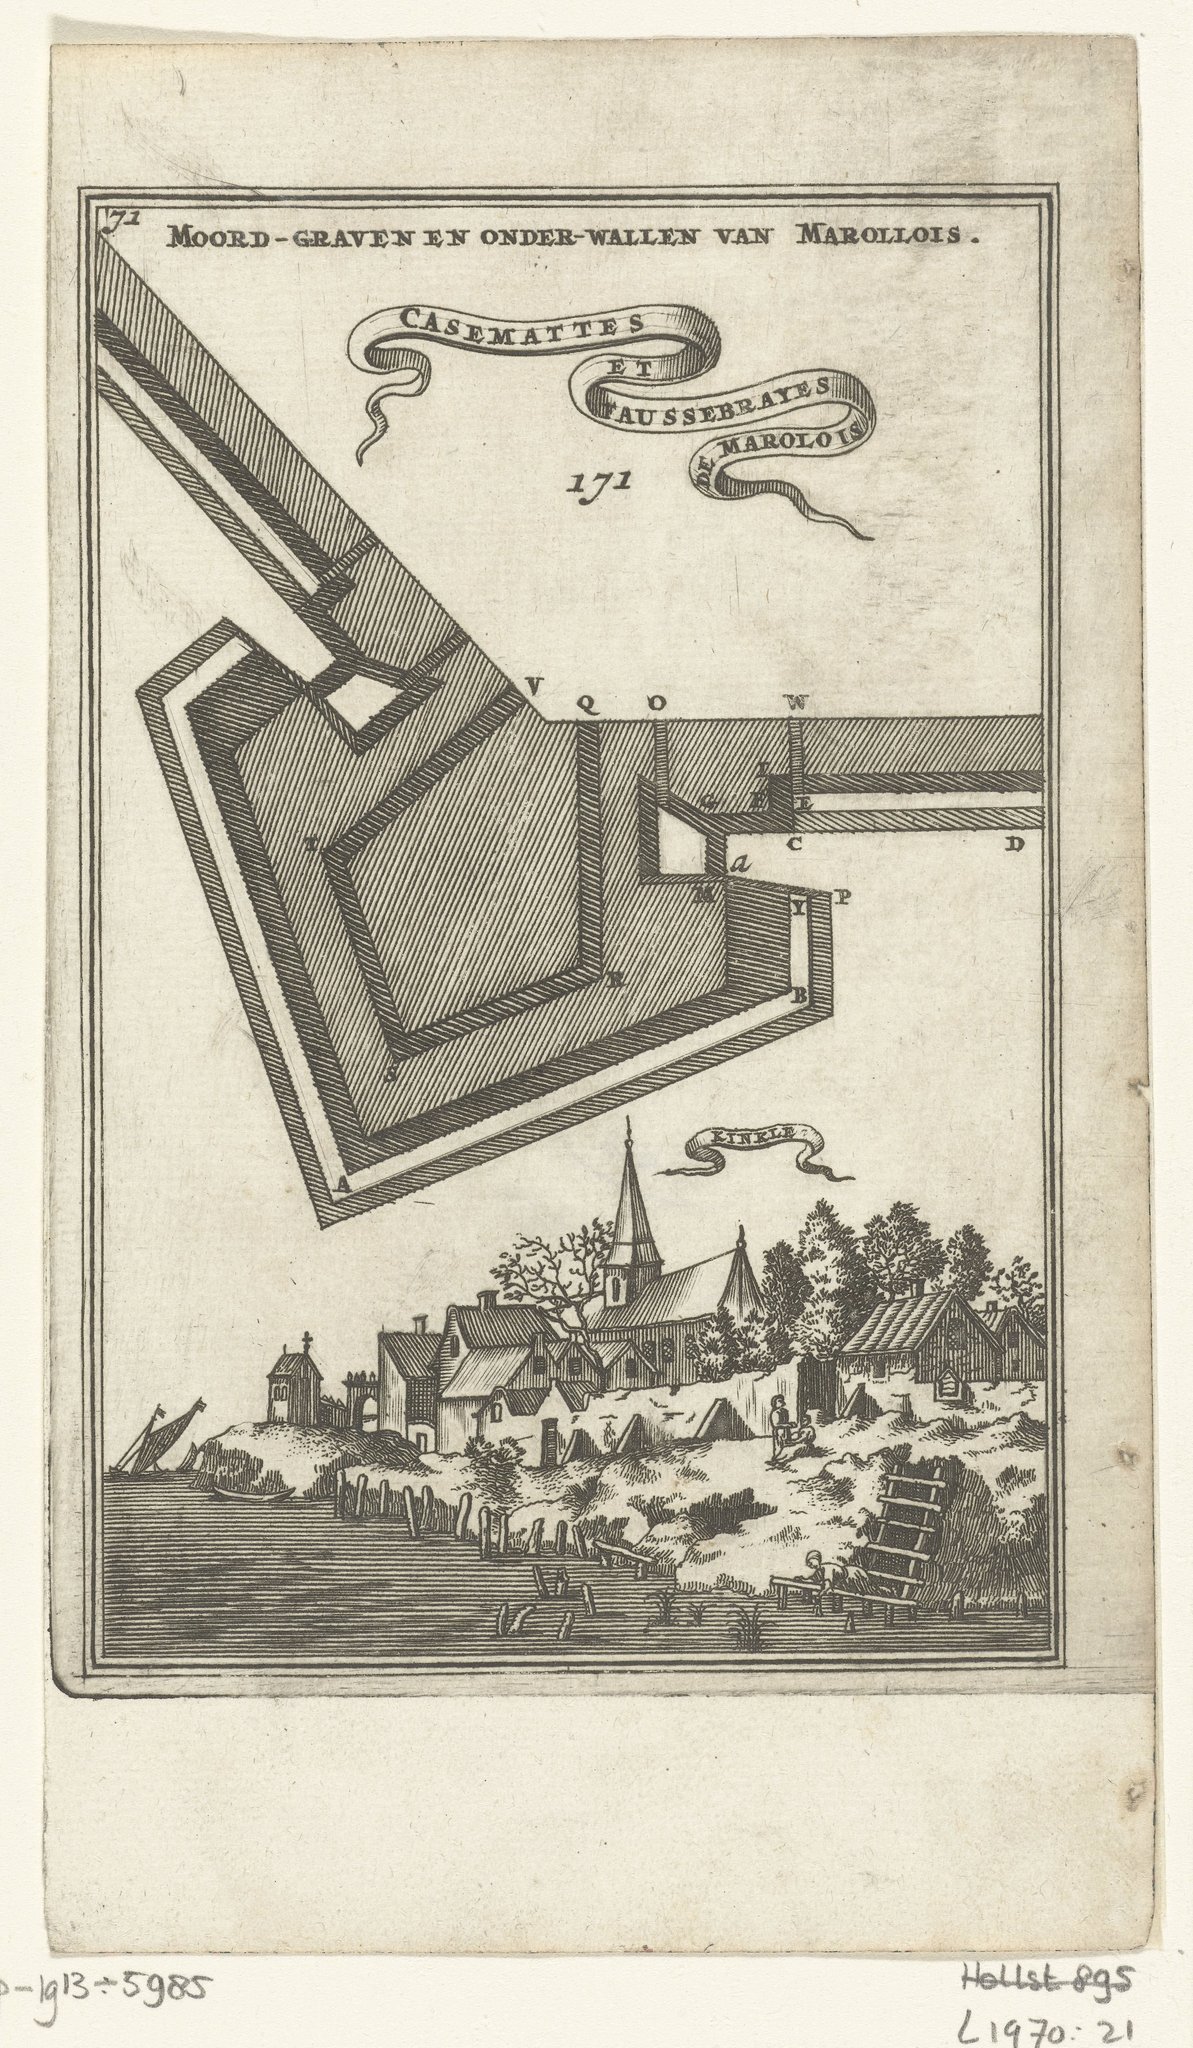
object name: print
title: Illustratie voor 'Den Arbeid van Mars' van Allain Manesson Mallet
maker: romeyn de hooghe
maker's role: draughtsman, goldsmith, painter, print maker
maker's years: 1645-1708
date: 1672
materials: paper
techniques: etching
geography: amsterdam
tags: prospect of village, silhouette of village, water course, fortifications, military engineering, mathematics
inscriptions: collector's mark: Lugt 2228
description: Grondplan voor een deel van een vesting, fort of versterking. Daaronder een gezicht op een dorp aan een water ("Kinkle'). In de hoek linksboven het cijfer 71 (= het nummer van de pagina in het boek waartegenover de illustratie geplaatst is).